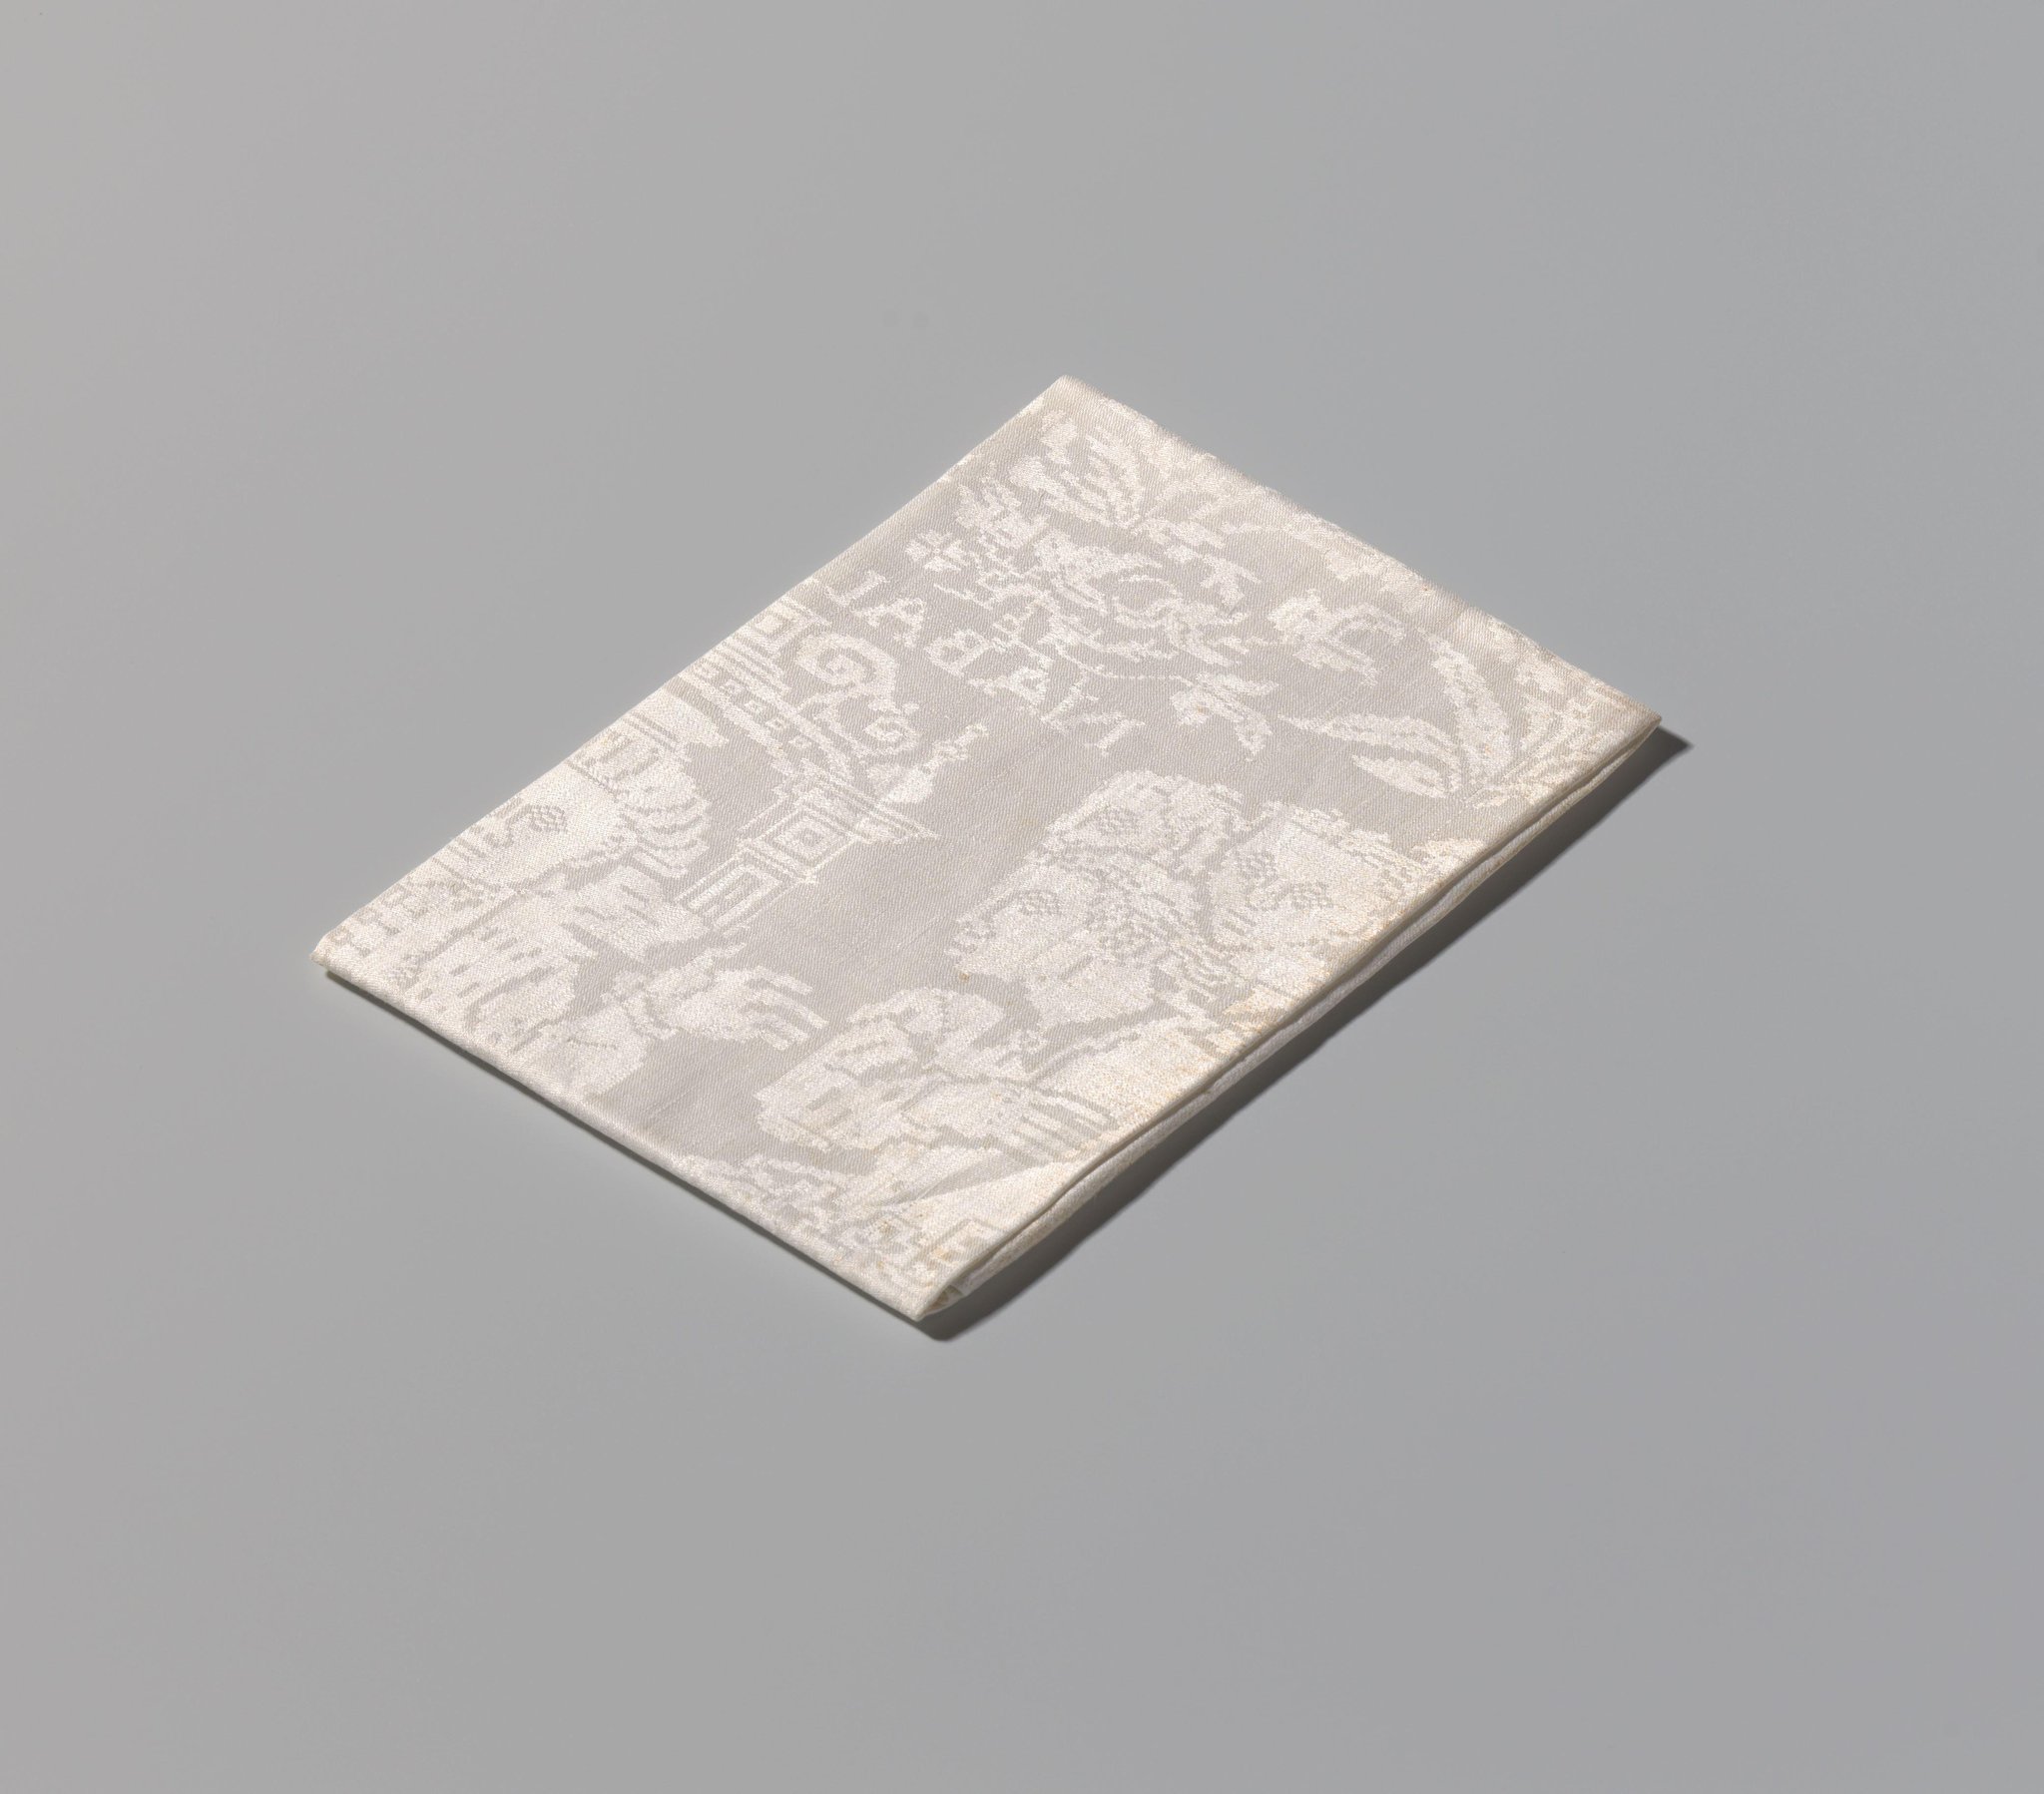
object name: napkin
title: Servet met Nabal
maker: quirijn jansz. damast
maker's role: mayor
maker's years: 1580-1638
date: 1620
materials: linen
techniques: damask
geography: haarlem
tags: david and abigail (1 samuel 25)